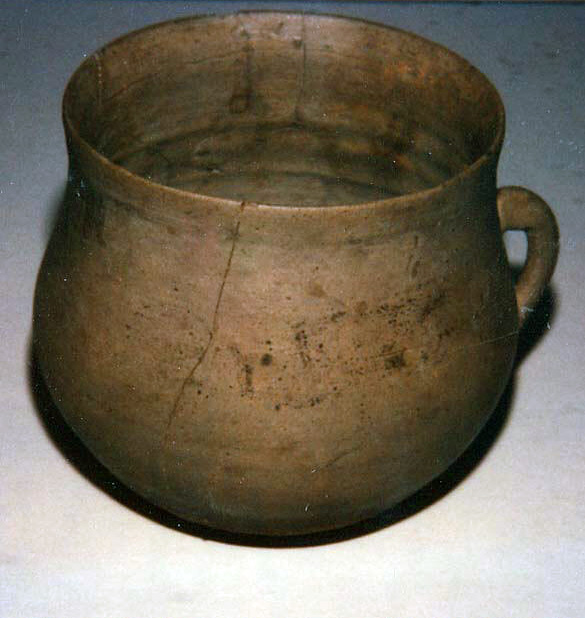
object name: cup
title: Cup with handle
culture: korean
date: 401-600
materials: wood, glaze, stoneware